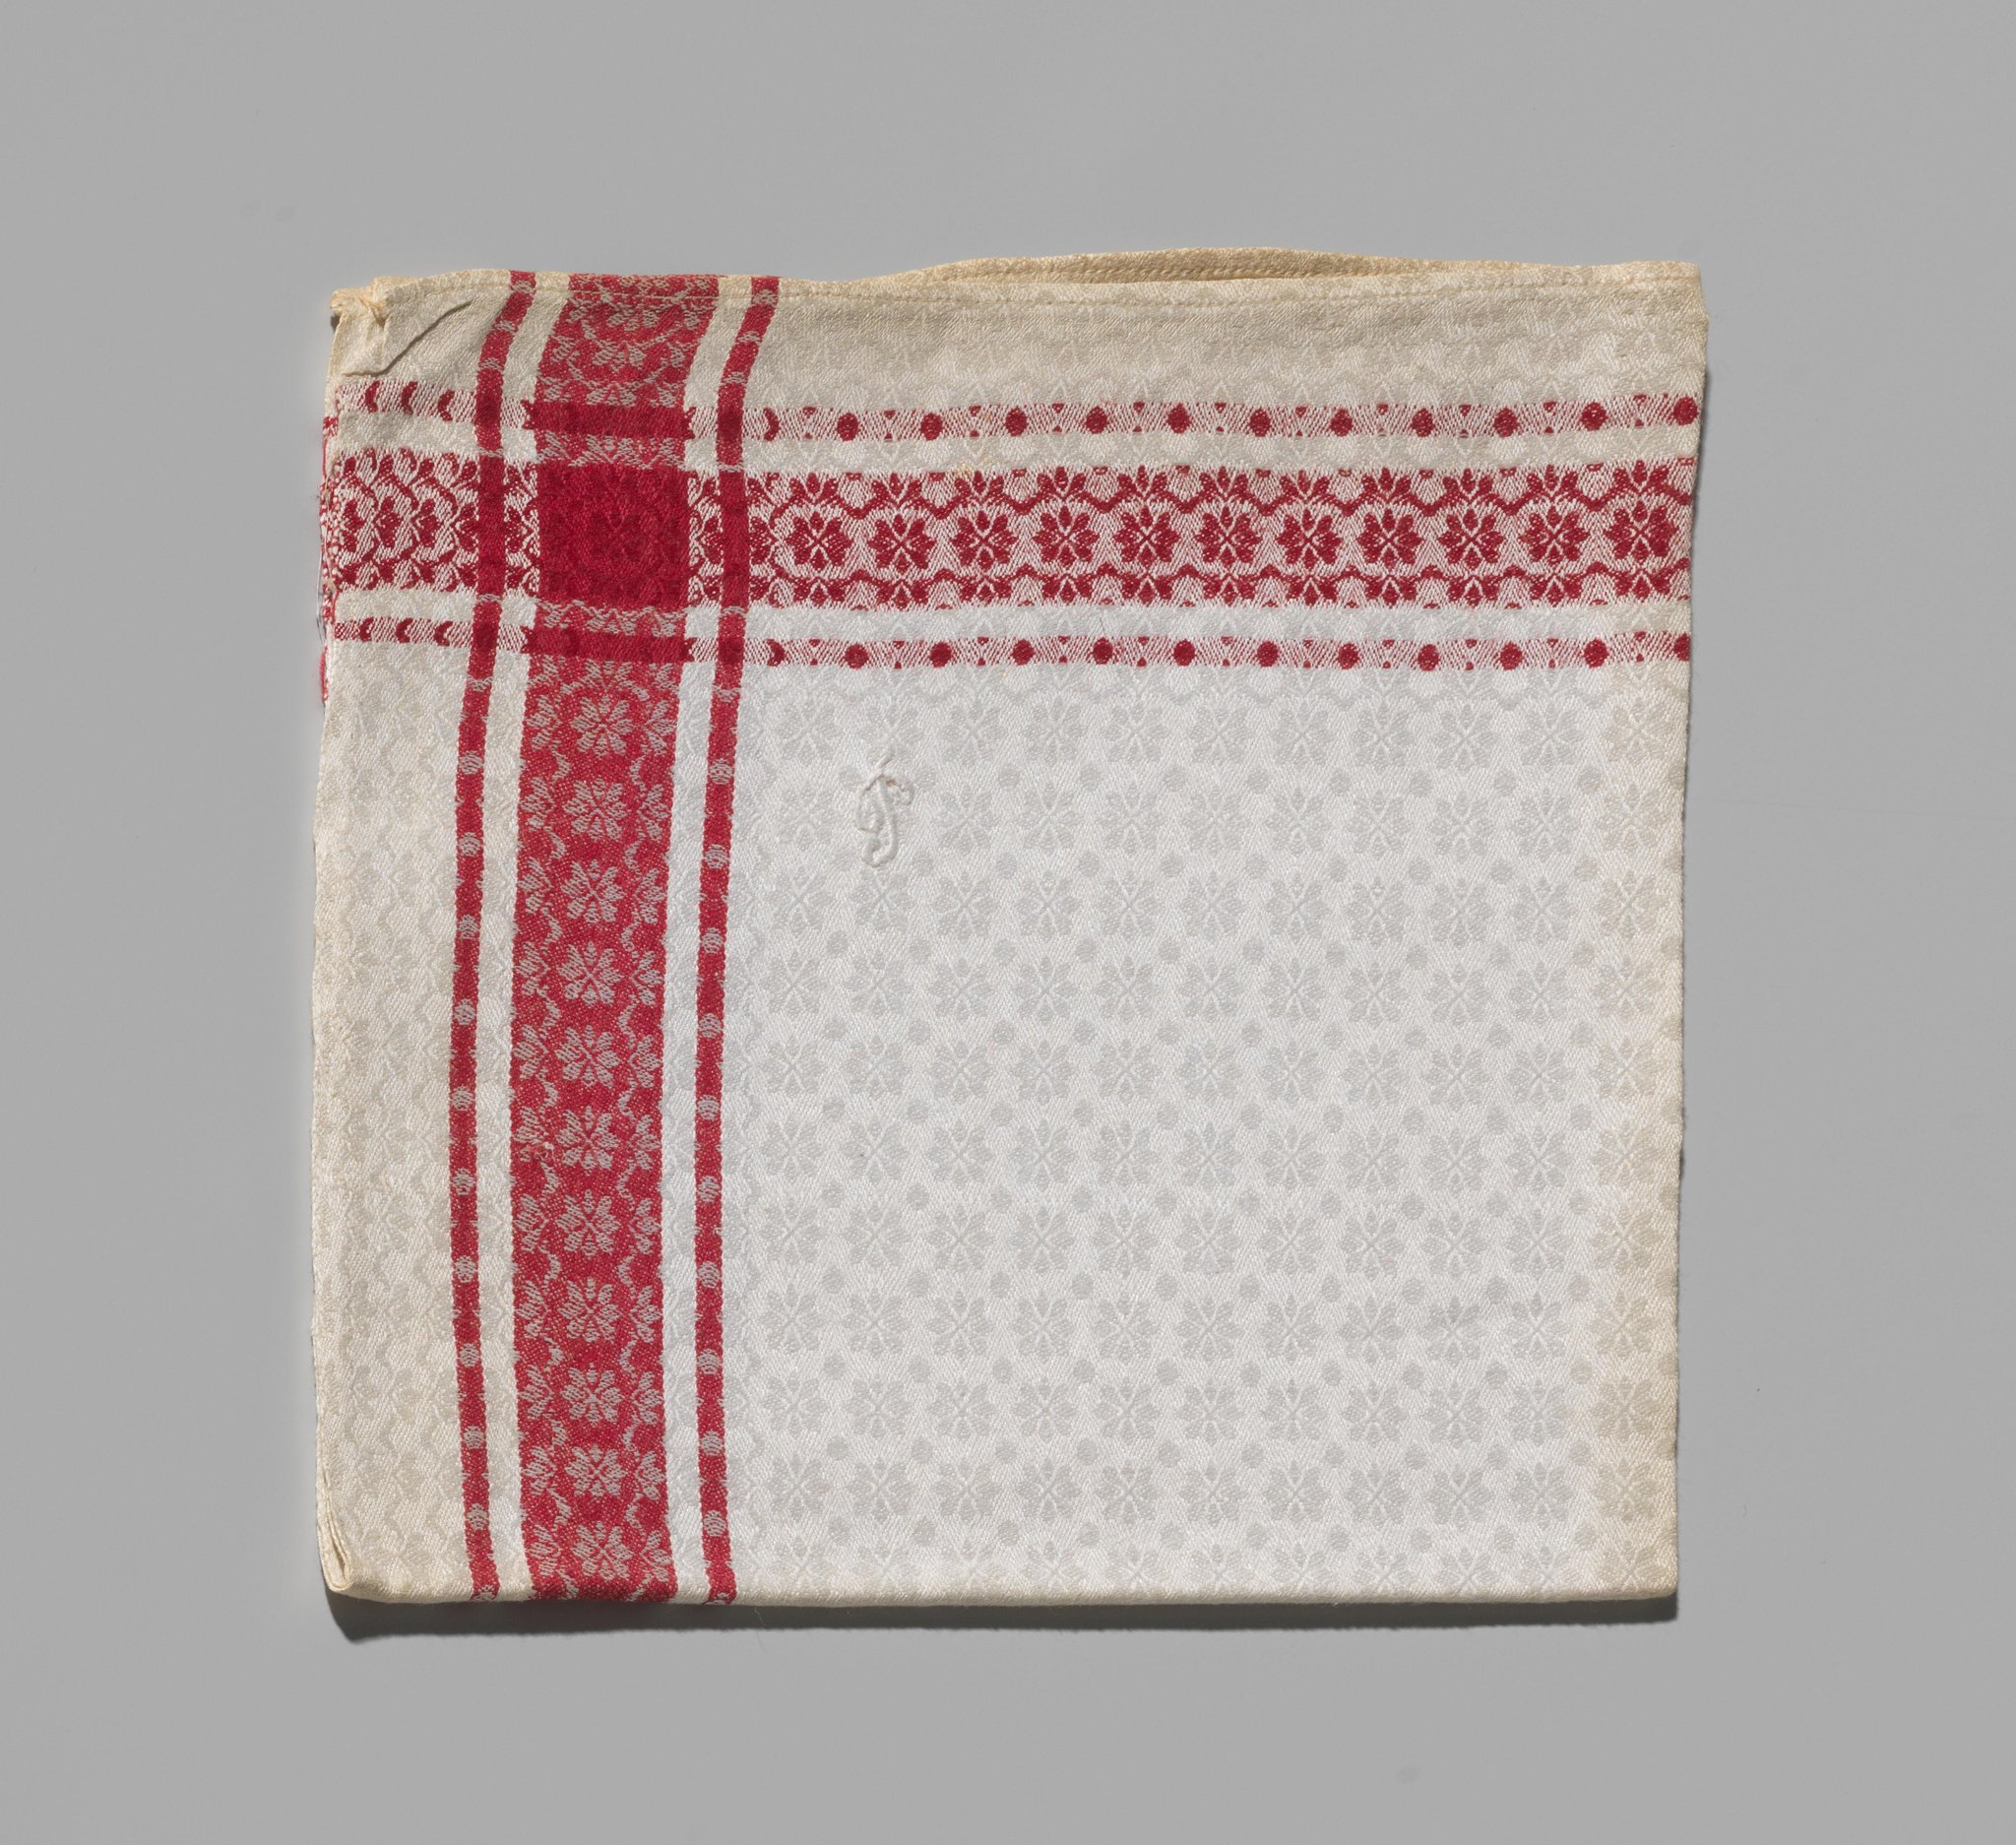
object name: vingerdoek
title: Vingerdoek van linnendamast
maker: Anonymous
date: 1900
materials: linen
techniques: damask, weave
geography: germany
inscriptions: monogram: ‘P’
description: Vingerdoek van linnendamast met rode ingeweven randen. Het patroon heeft sterren (of bloemen) en moesjes. De dubbele randen hebben sterren (of bloemen) en bladeren, geflankeerd door smalle randen met moesjes. In een hoek een in wit geborduurde letter P. De vingerdoek hoort bij elf vingerdoeken (BK-1980-164-A t/m BK-1980-164-L) en een tafellaken (BK-1980-163).